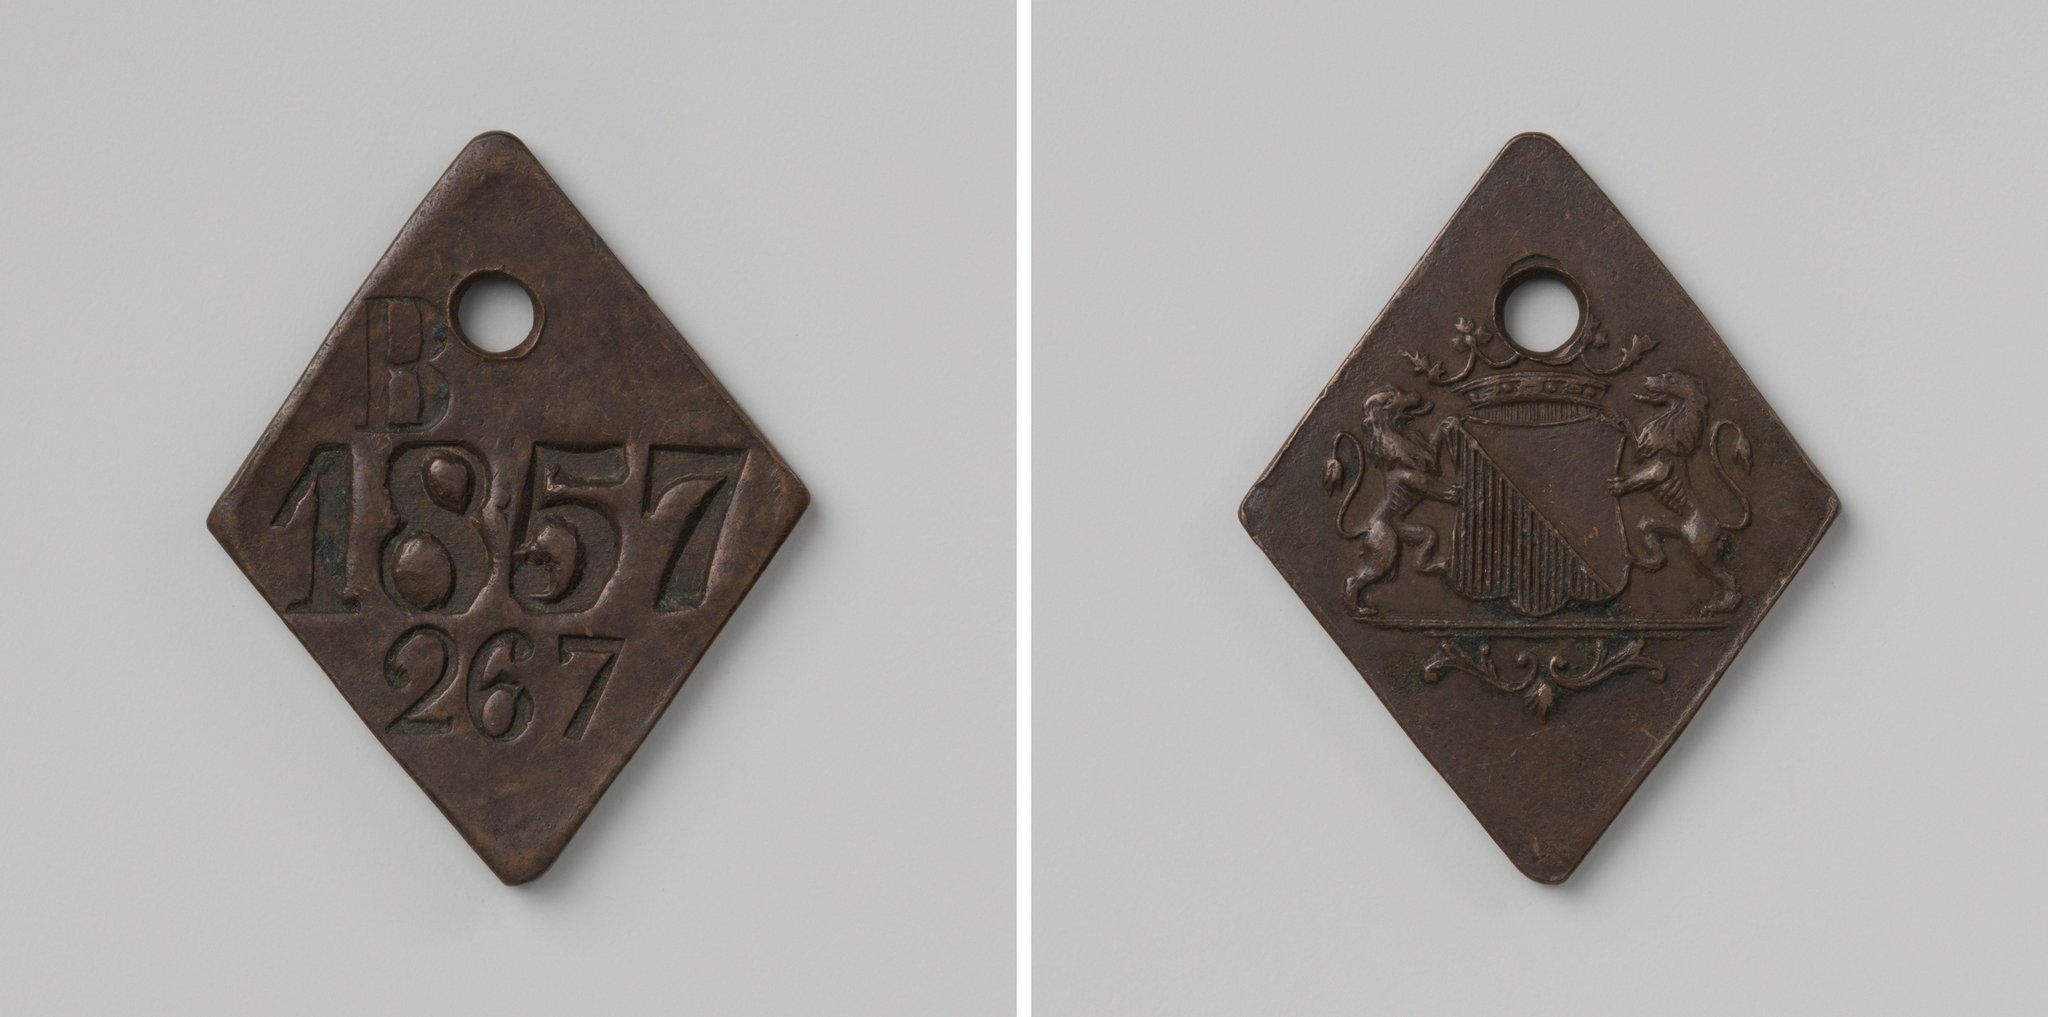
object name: tax token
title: Stad Utrecht, loodje met letter B en no. 267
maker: Anonymous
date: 1857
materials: copper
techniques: striking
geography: utrecht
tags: utrecht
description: ruitvormig loodje met afgeronde hoeken en gat erin. Voorzijde: letter B boven jaartal en cijfer 267. Keerzijde: gekroond wapenschild, geflankeerd door twee leeuwen